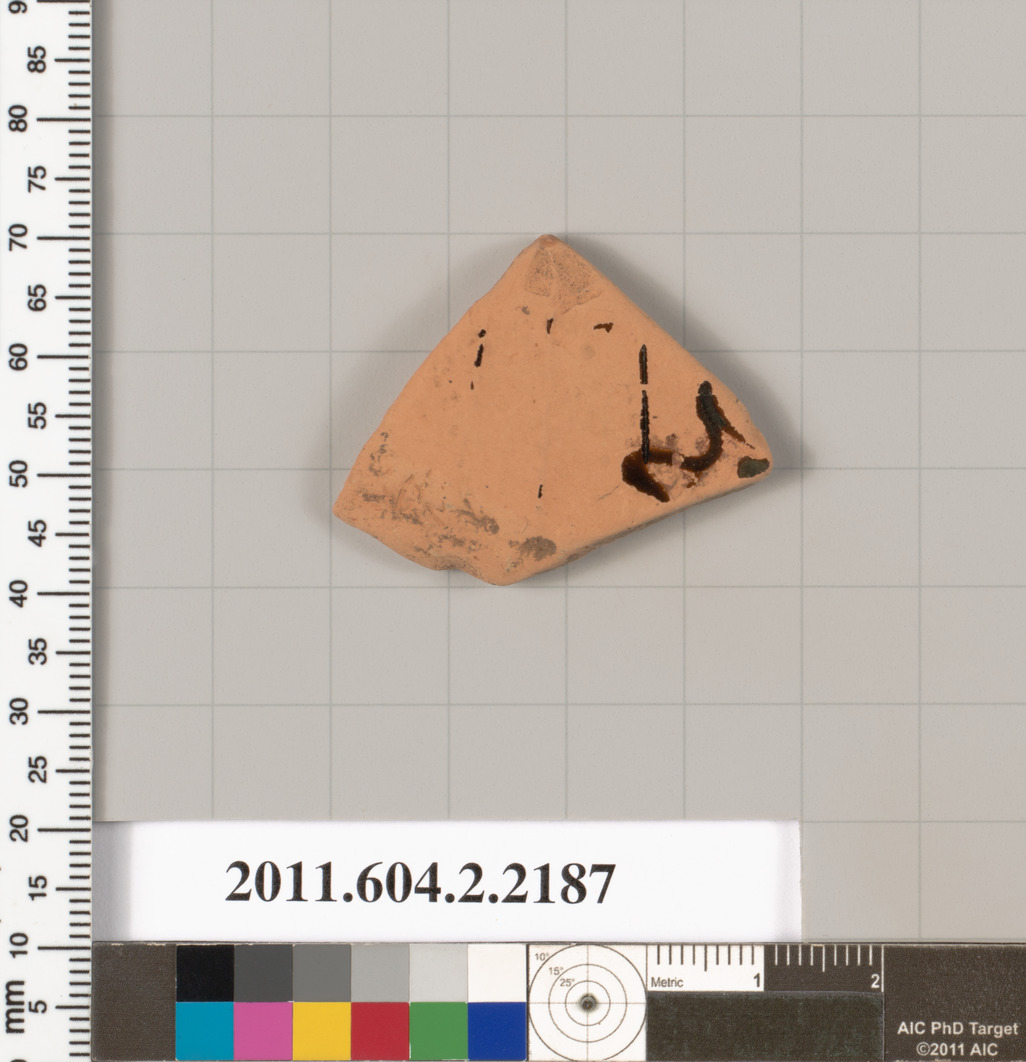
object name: pot fragment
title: Terracotta fragment of a pot; unglazed on the inside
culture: greek, attic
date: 467-435 BCE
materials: terracotta